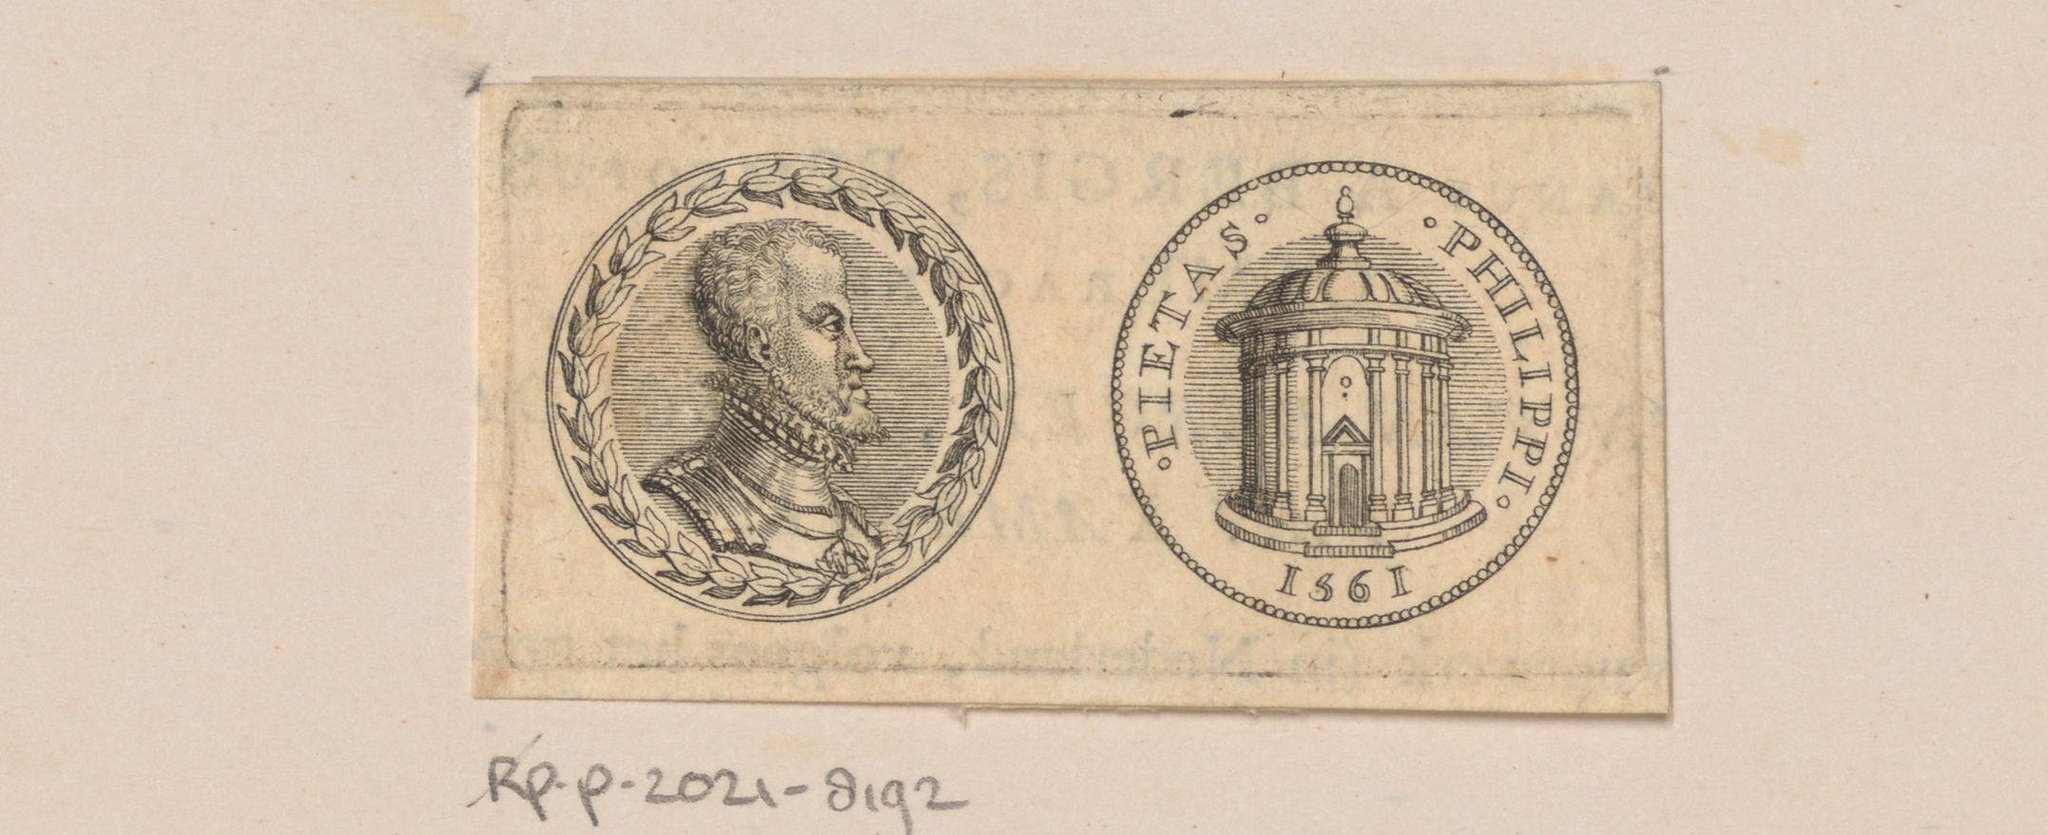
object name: book illustration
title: Penning met het portret van Filips II en een monument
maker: Anonymous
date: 1723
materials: paper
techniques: etching, letterpress printing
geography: the hague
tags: philip ii of spain, historical persons, coin, monumental adornments (in city)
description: Prent uit: Loon, Gerard van. Beschryving der Nederlandsche Historipenningen (...). Den Haag: Christiaan van Lom, Isaac Vaillant, Pieter Gosse, Rutger Alberts en Pieter de Hondt, 1723, dl. 1.